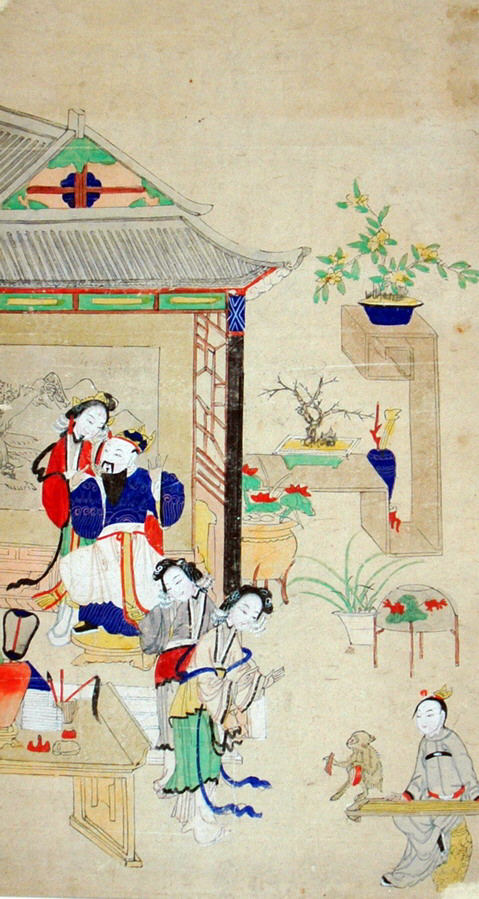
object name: print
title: Bo Yi Gao and the White Gibbon Entertain King Zhou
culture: chinese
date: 1801-1900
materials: ink, paper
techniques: polychrome, woodblock print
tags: kings,women,flowers